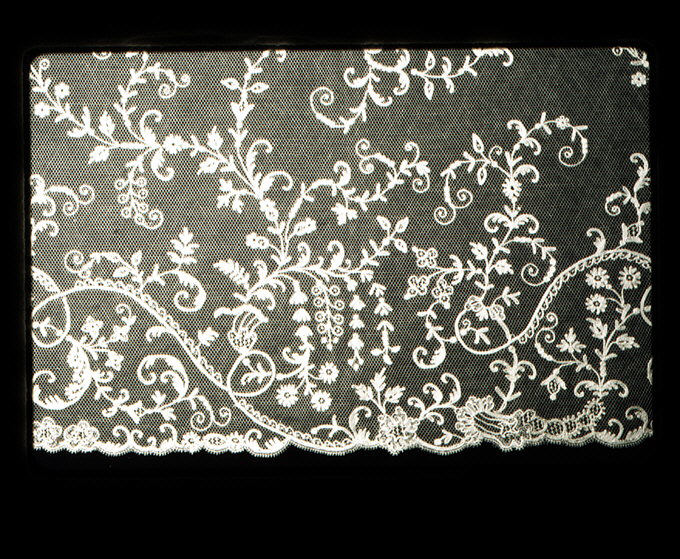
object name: veil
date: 1801-1900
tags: flowers